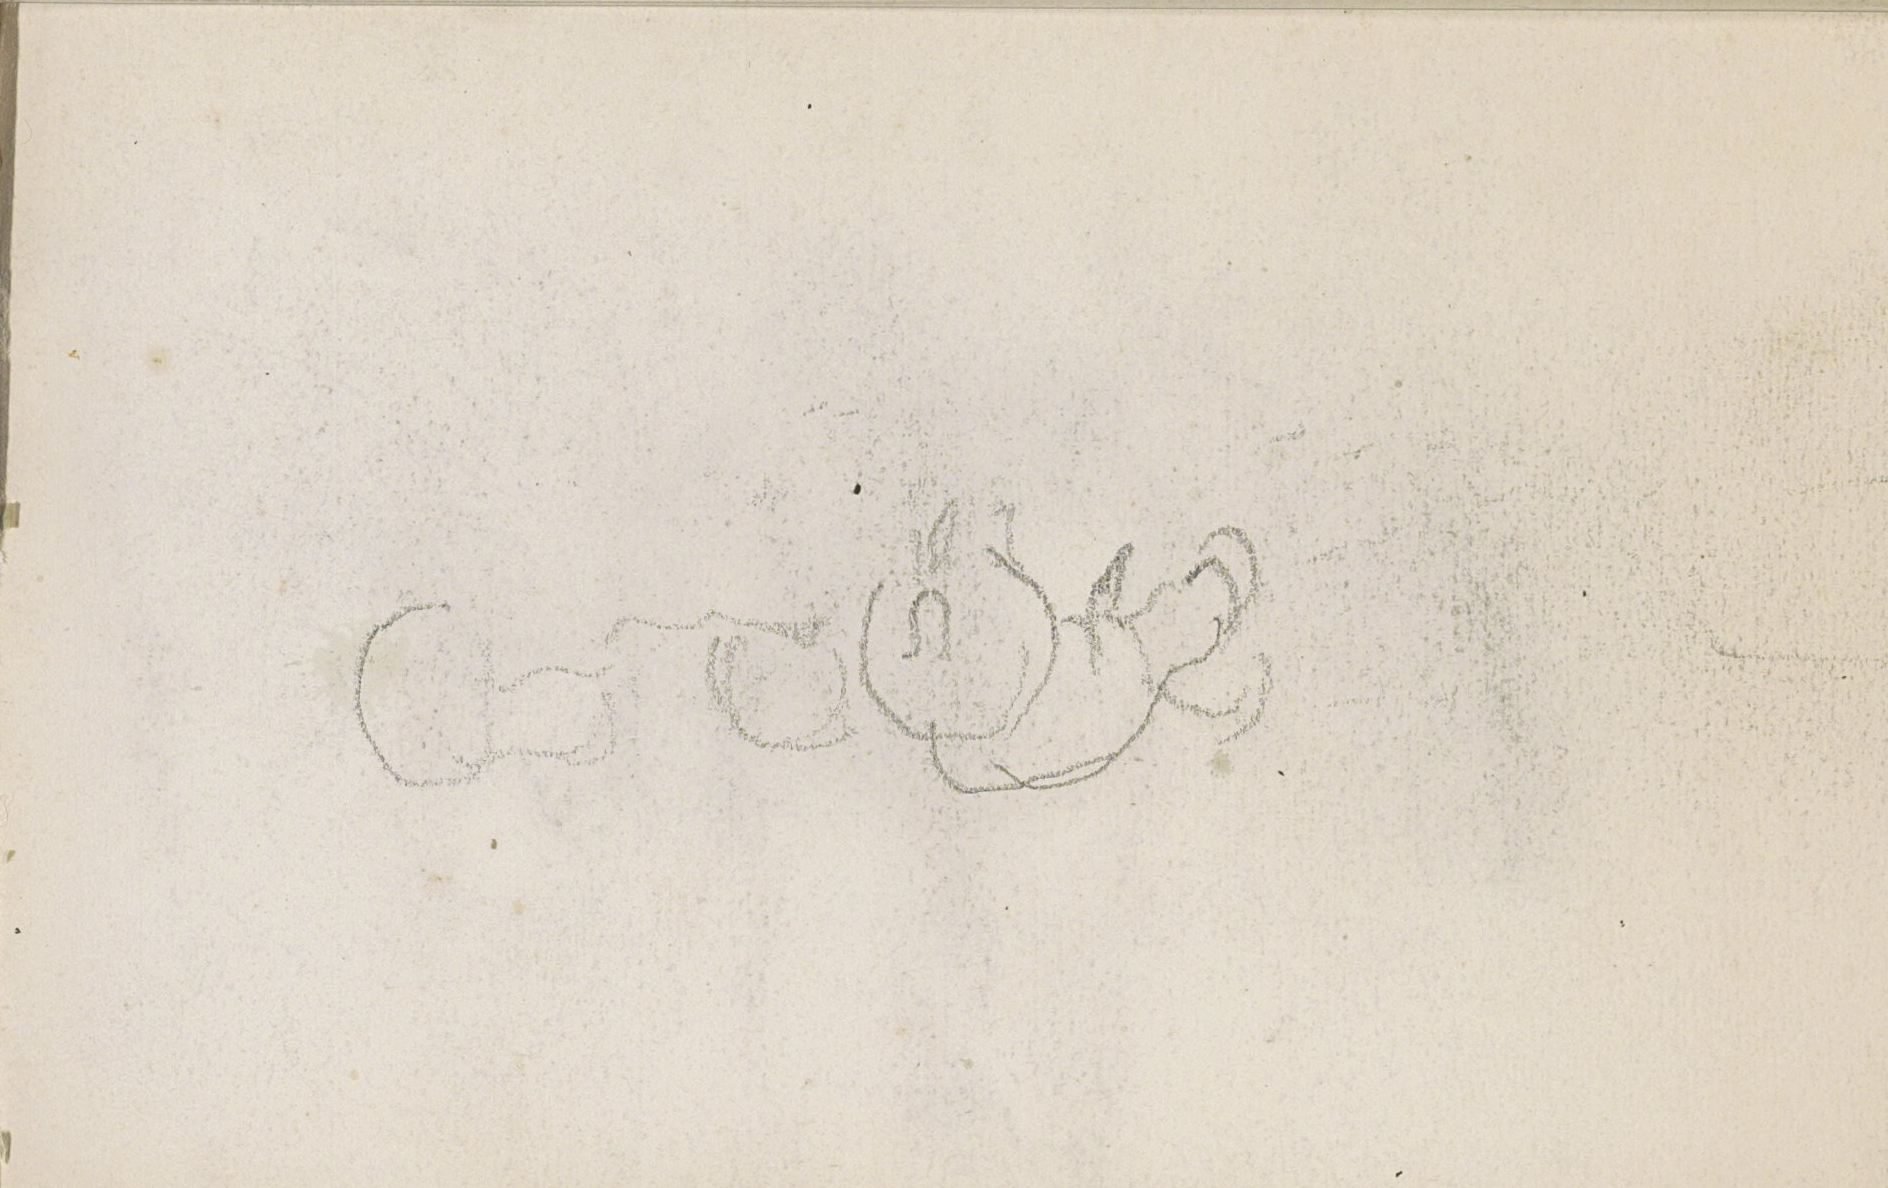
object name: sketchbook leaf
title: Schapen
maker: anton mauve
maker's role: draughtsman, painter, print maker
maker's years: 1838-1888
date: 1848-1888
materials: paper, pencil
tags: sheep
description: Blad 2 recto uit een schetsboek met 44 bladen.